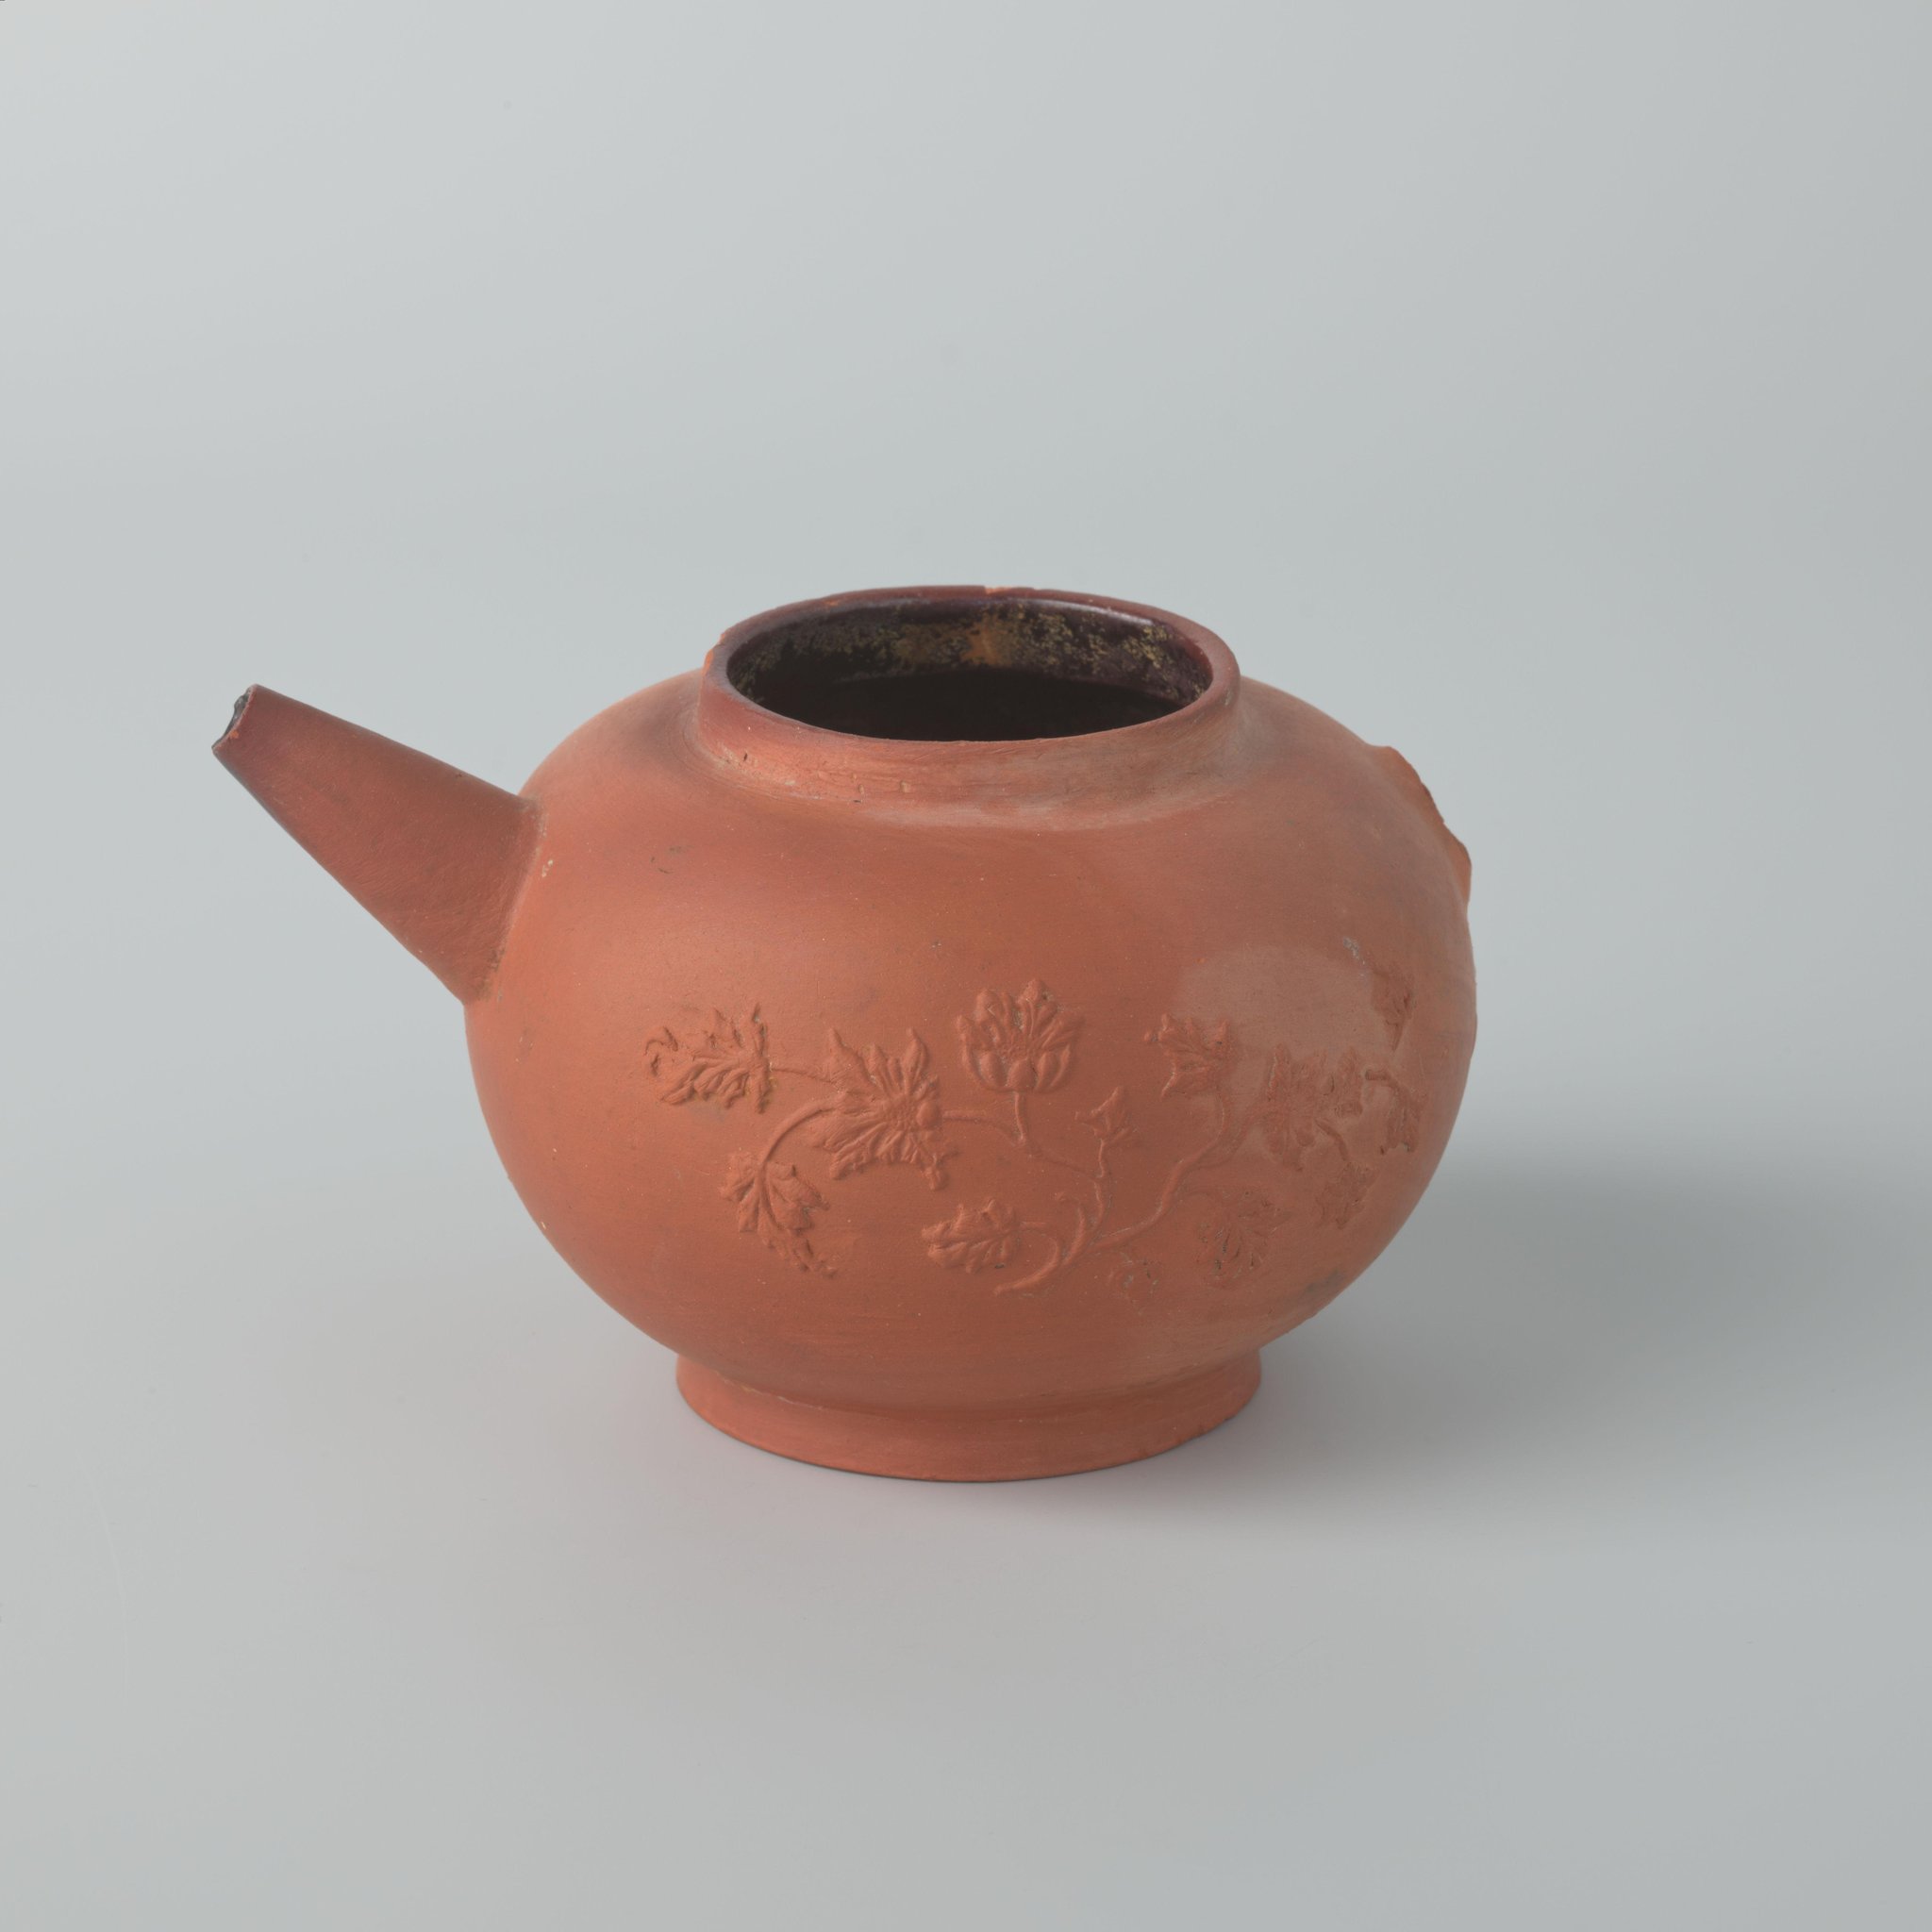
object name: teapot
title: Theepot met bloemranken in reliëf (De caluwe bakafval)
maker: jacobus de caluwe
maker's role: plateelbakkerij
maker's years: -1730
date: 1700-1725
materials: earthenware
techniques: firing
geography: delft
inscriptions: mark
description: Ronde theepot met een rechte rand en voet, en met een conische tuit. Op beide zijden een bloemtak in reliëf. Gemaakt van in verschillende tinten oranjebakkende klei en voorzien van een laag donkerbruin glazuur aan de binnenzijde, én op het uiteinde van de tuit. Ovaal merk op de bodem (rennend hert). Deksel en oor ontbreken.